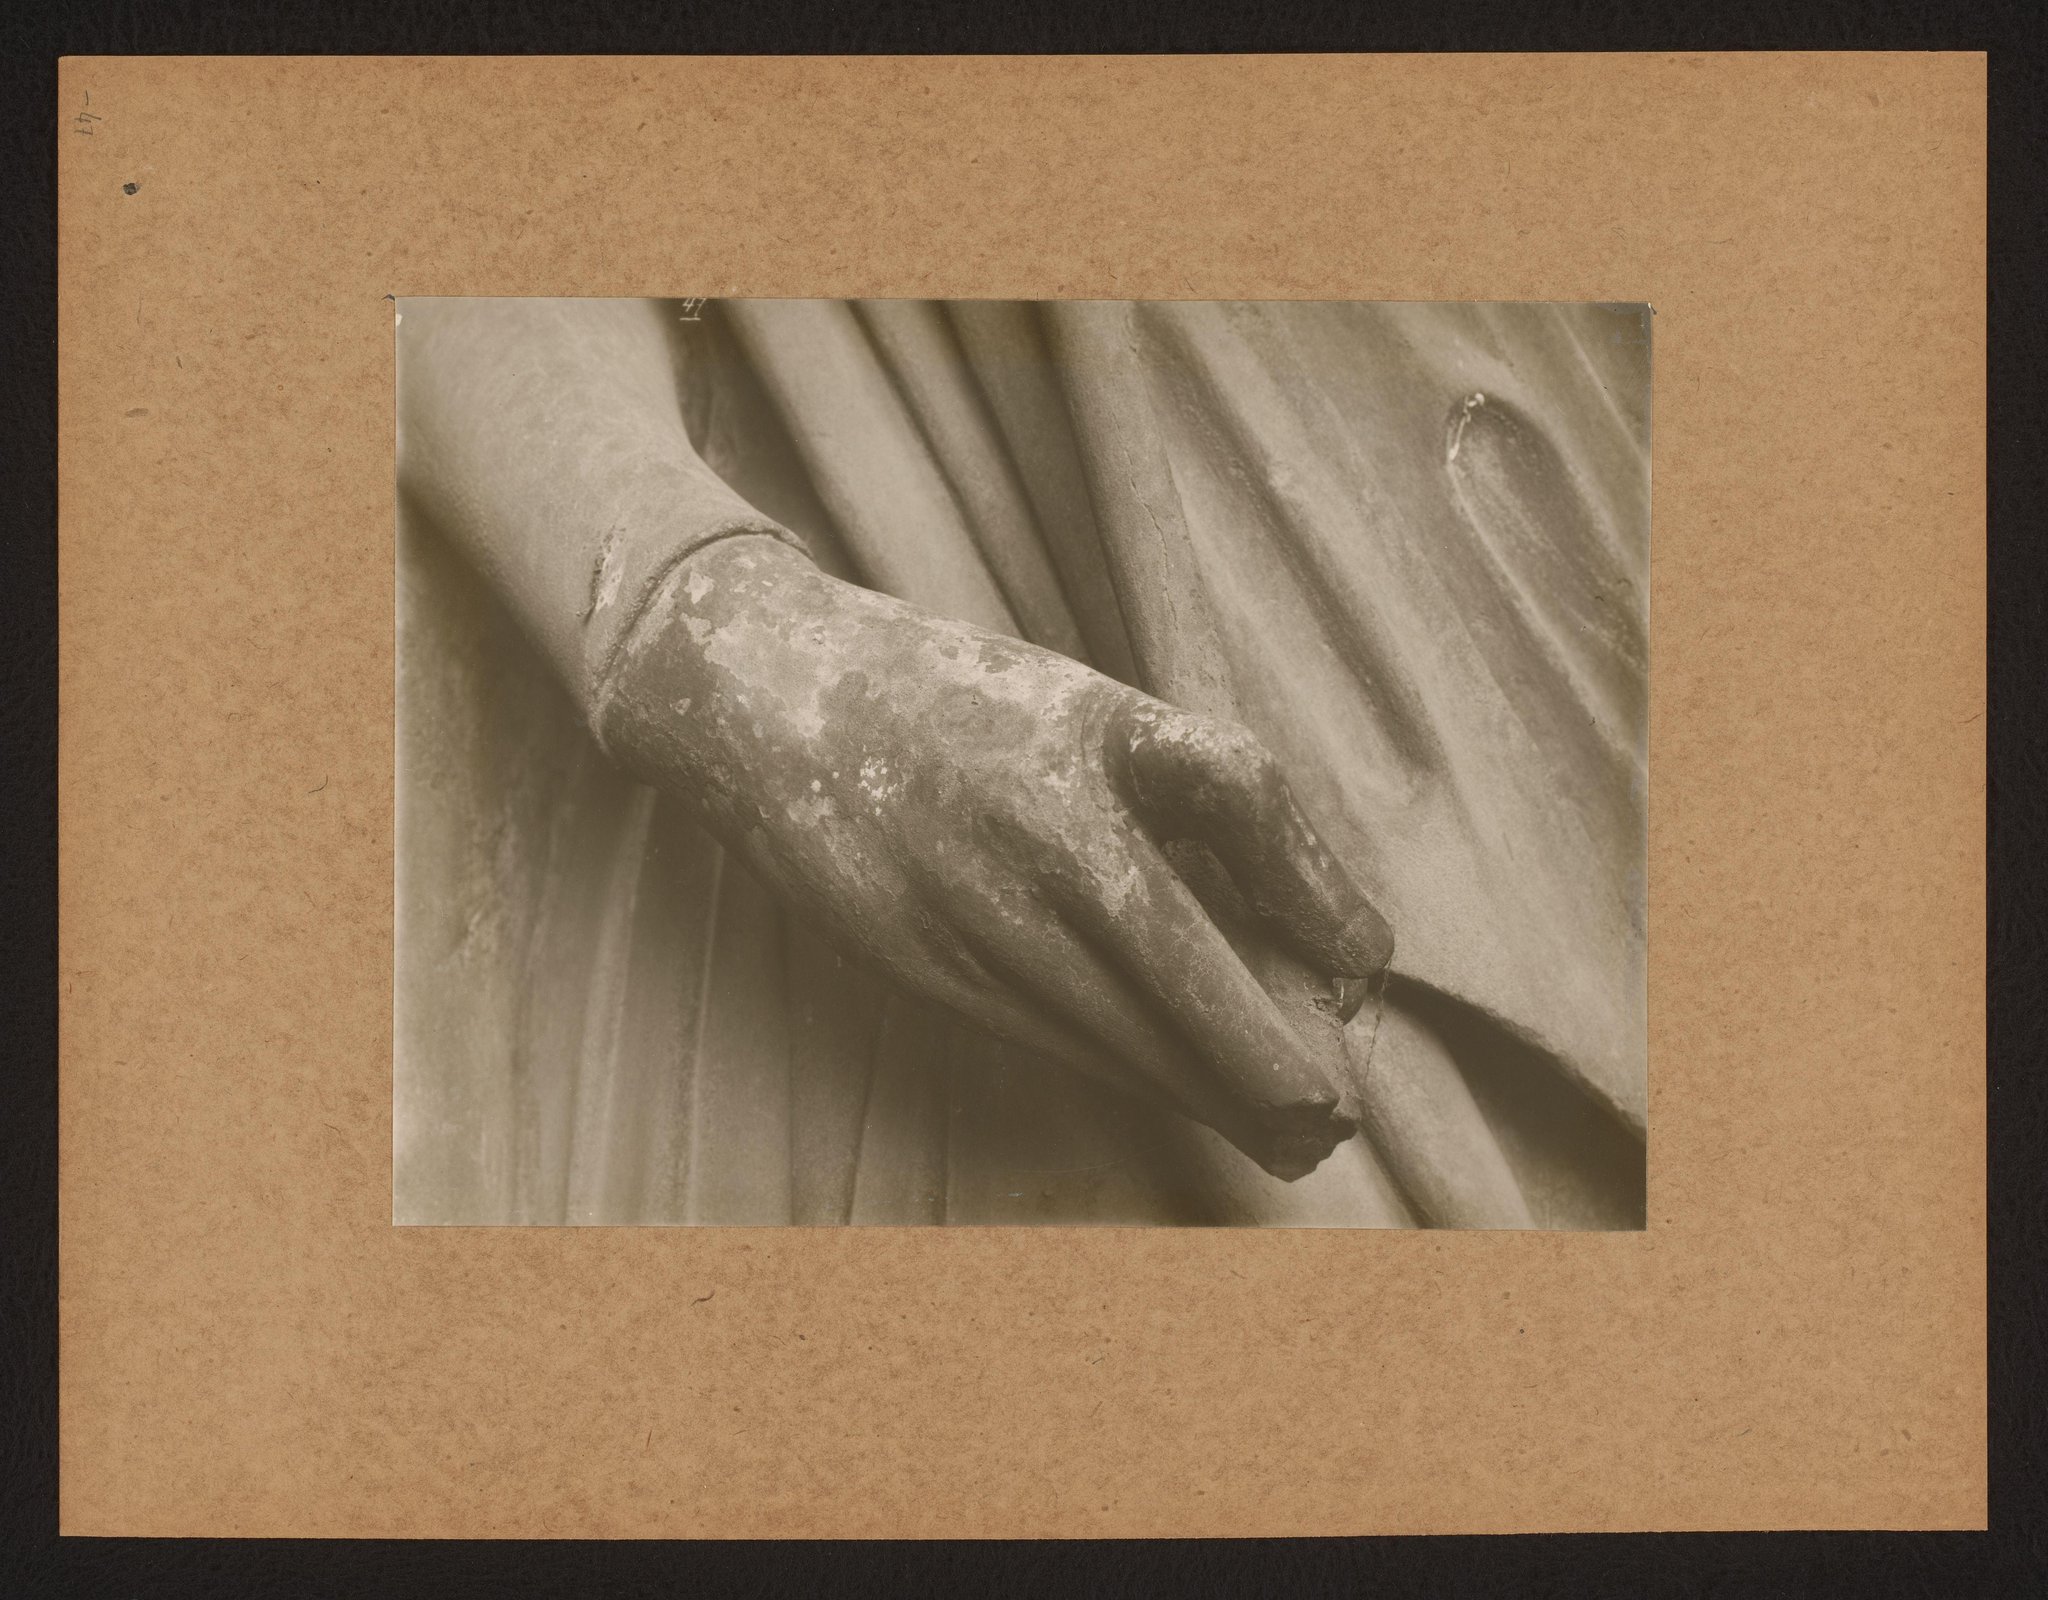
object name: album leaf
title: Detail van de Adamspforte in de dom van Bamberg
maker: Anonymous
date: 1900-1920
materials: paper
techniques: gelatin silver print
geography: bamberg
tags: church (exterior)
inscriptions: number: ‘47.’